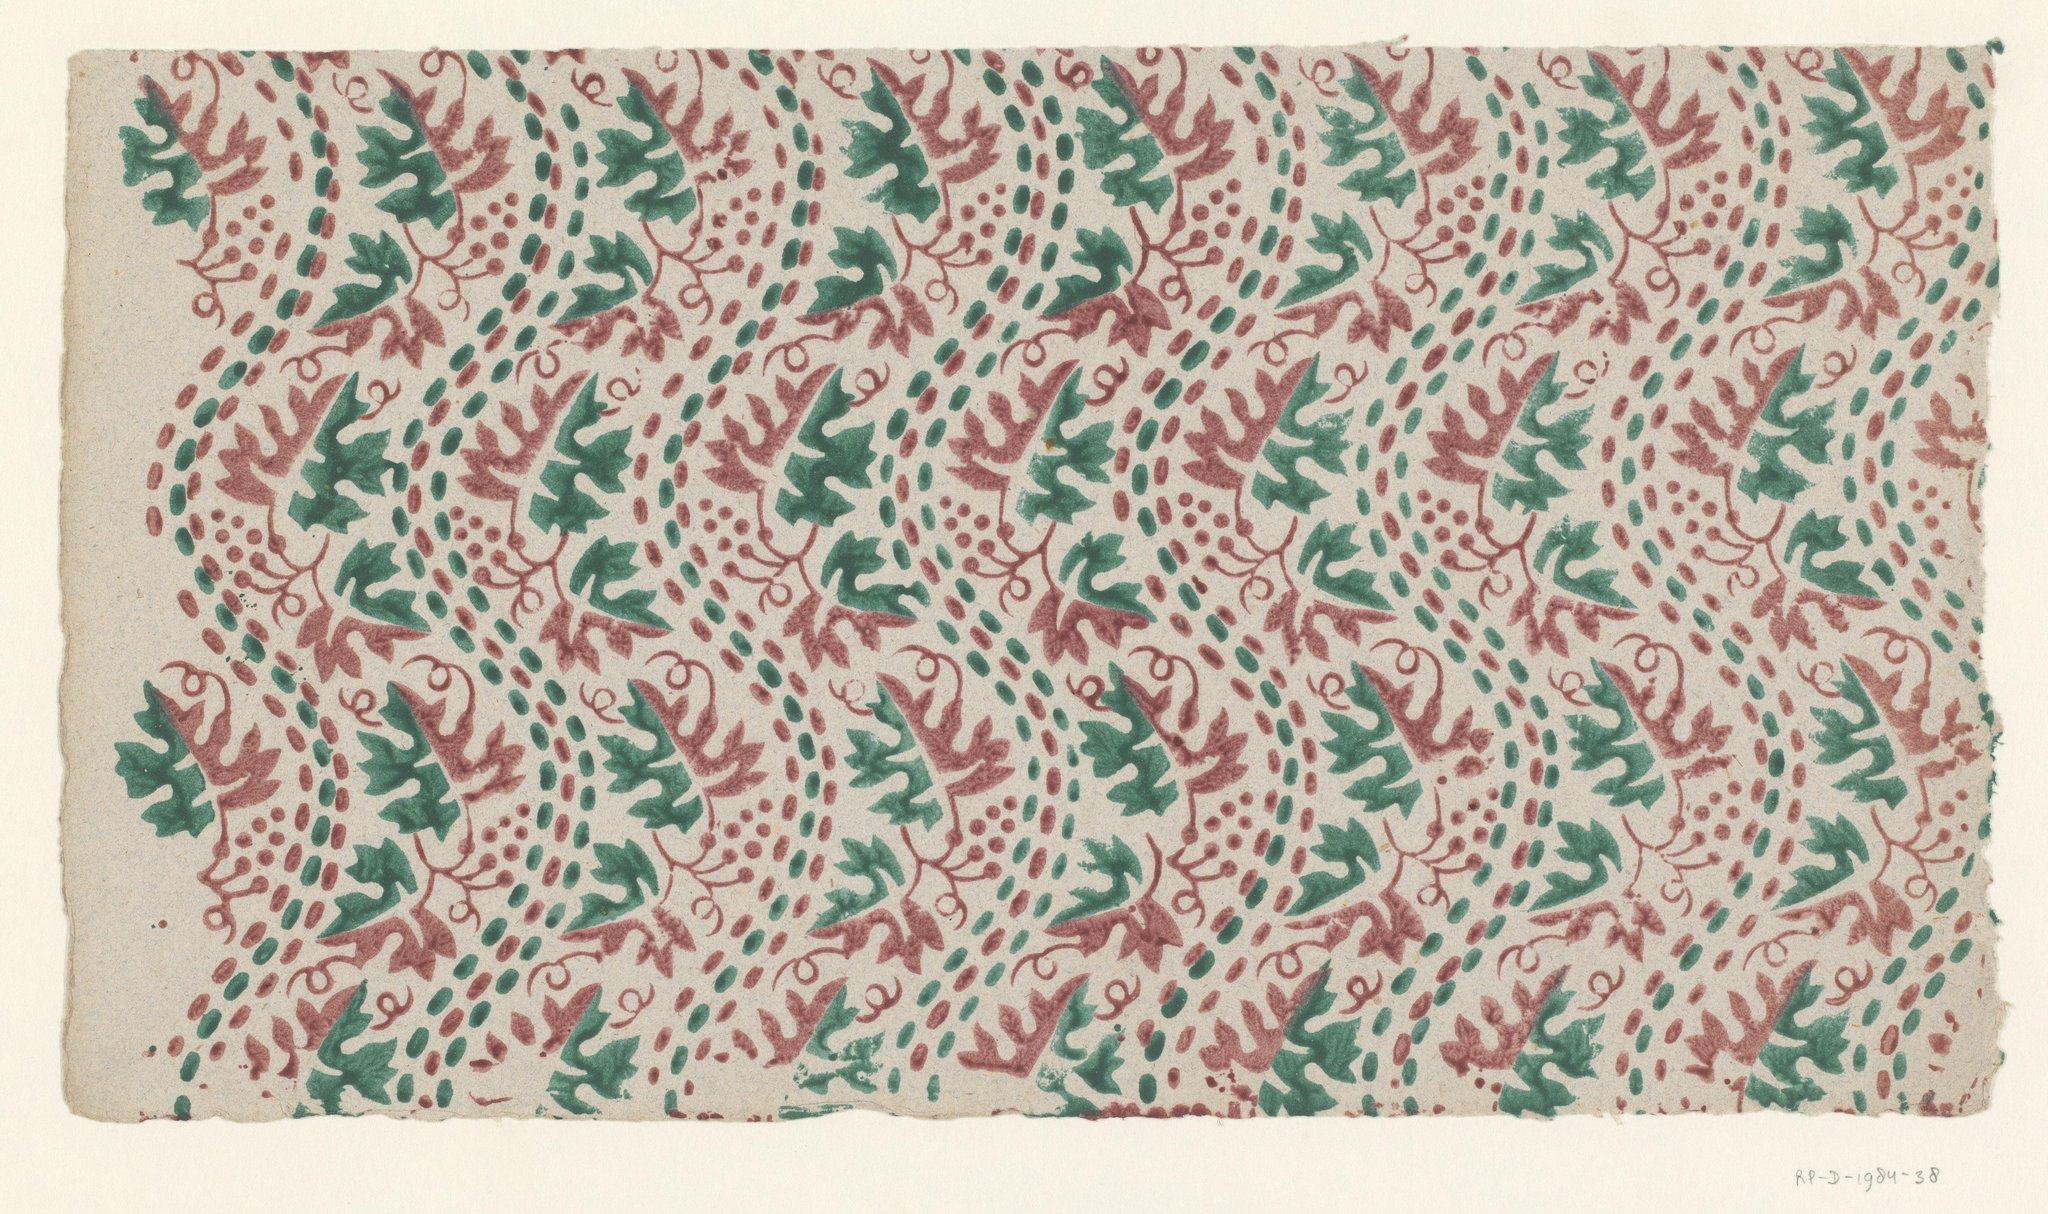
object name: printed paper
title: Blad met golvend banenpatroon van bladranken tussen stippellijnen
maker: Anonymous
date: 1750-1900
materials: paper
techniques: printing block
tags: ornament derived from plant forms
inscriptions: collector's mark: Lugt 2228